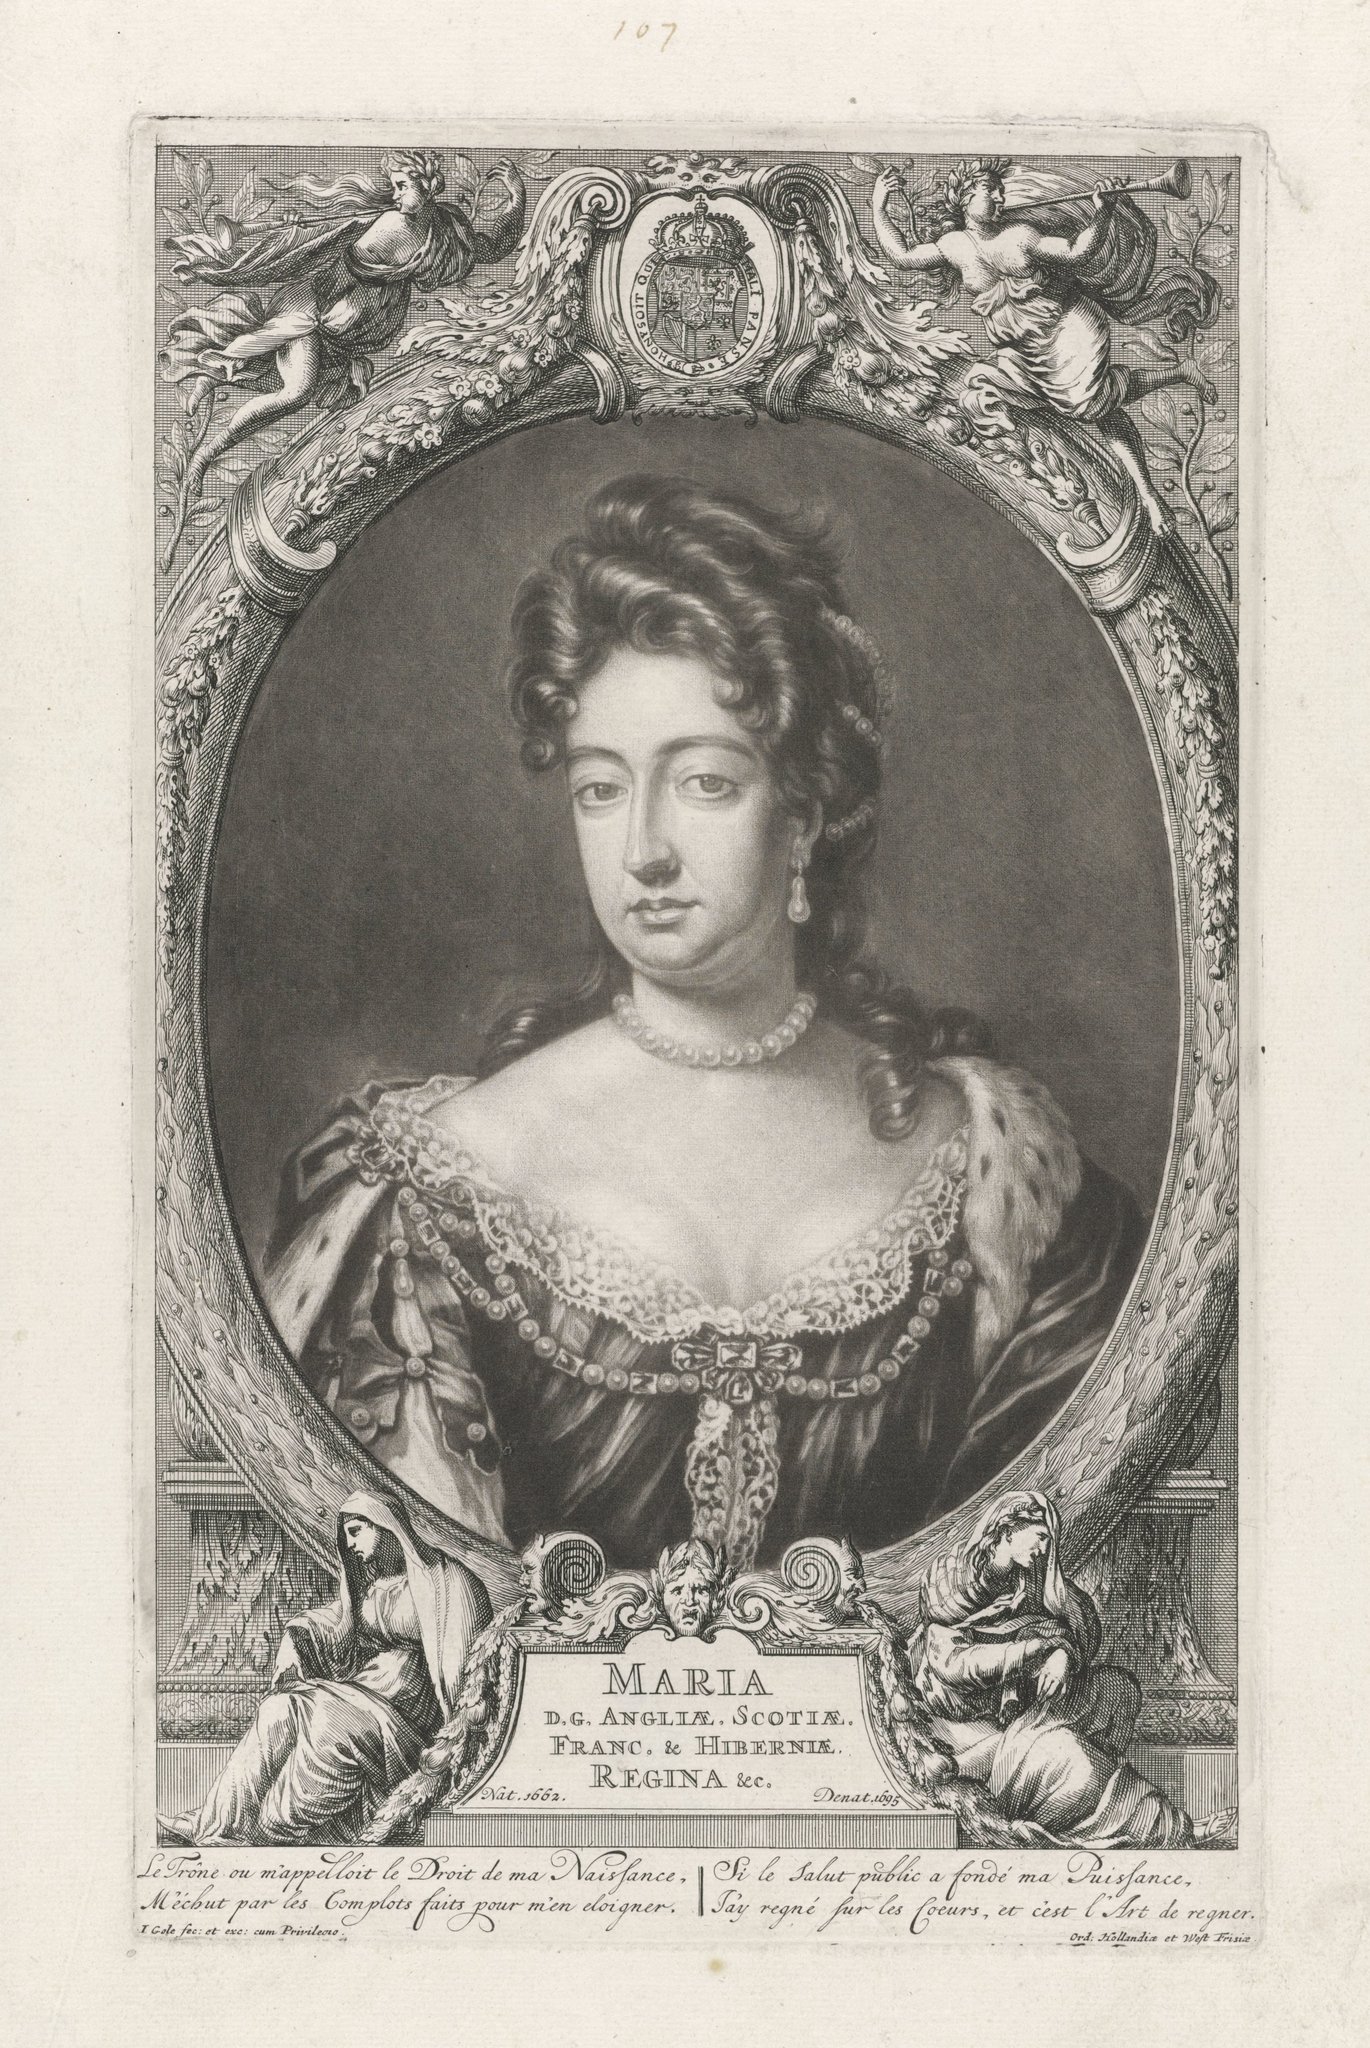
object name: print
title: Portret van Maria II Stuart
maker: jacob gole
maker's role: print maker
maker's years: 1660-1724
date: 1695-1724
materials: paper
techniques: etching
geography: amsterdam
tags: london, maria ii stuart (koningin van engeland, schotland en ierland), knighthood order (garter) - insignia of a knighthood order, e.g.: badge, chain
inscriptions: collector's mark: Lugt 2760, collector's mark: Lugt 2228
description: Portret van Maria II in een ovaal van lauwerbladen en oranjetakken. Daar omheen een aantal allegorische objecten en figuren. Midden boven haar wapen met een kroon, gedecoreerd met de Kousenband en het devies van de Orde van de Kousenband. Op een voetstuk haar geboortejaar, sterfjaar en haar naam en titels. In de ondermarge twee kolommen met elk twee regels Franse tekst.